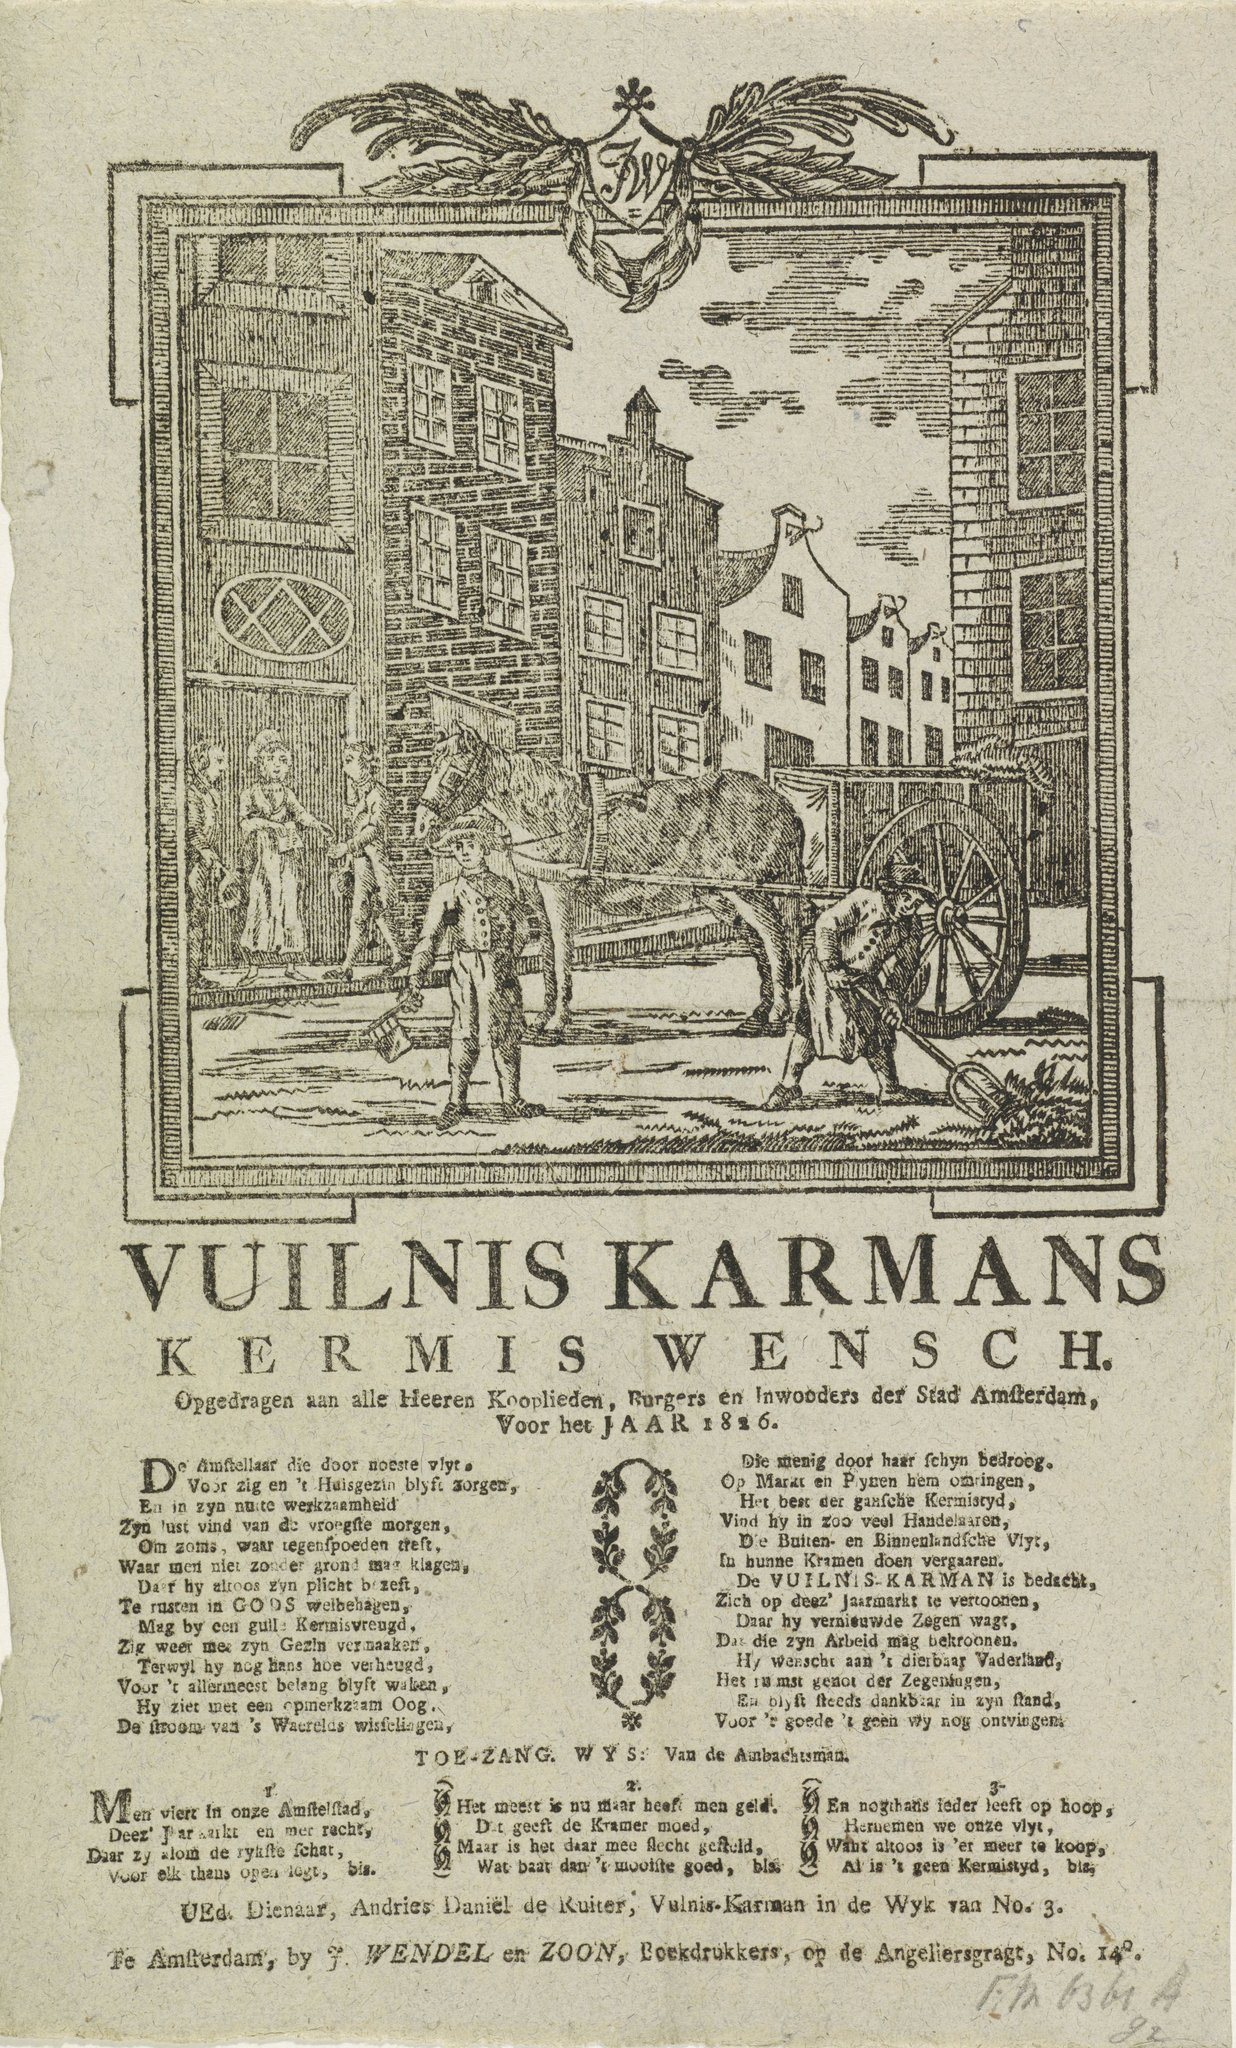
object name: fair print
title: Kermisprent van de vuilnismannen van Amsterdam voor het jaar 1826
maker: Anonymous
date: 1826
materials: paper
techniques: letterpress printing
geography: amsterdam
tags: street, garbage collection, amsterdam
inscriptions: collector's mark: Lugt 2228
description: Kermisprent van de Amsterdamse vuilnismannen voor het jaar 1826. Gezicht in een straat te Amsterdam waar een man met een kar vuil van straat schept, bij hem een man met een ratel. Twee andere mannen halen bij een huis geld op. Met gedicht in twee kolommen en een lied in drie verzen. Van de vuilniskarman in de wijk no. 3: Andries Daniel de Ruiter.